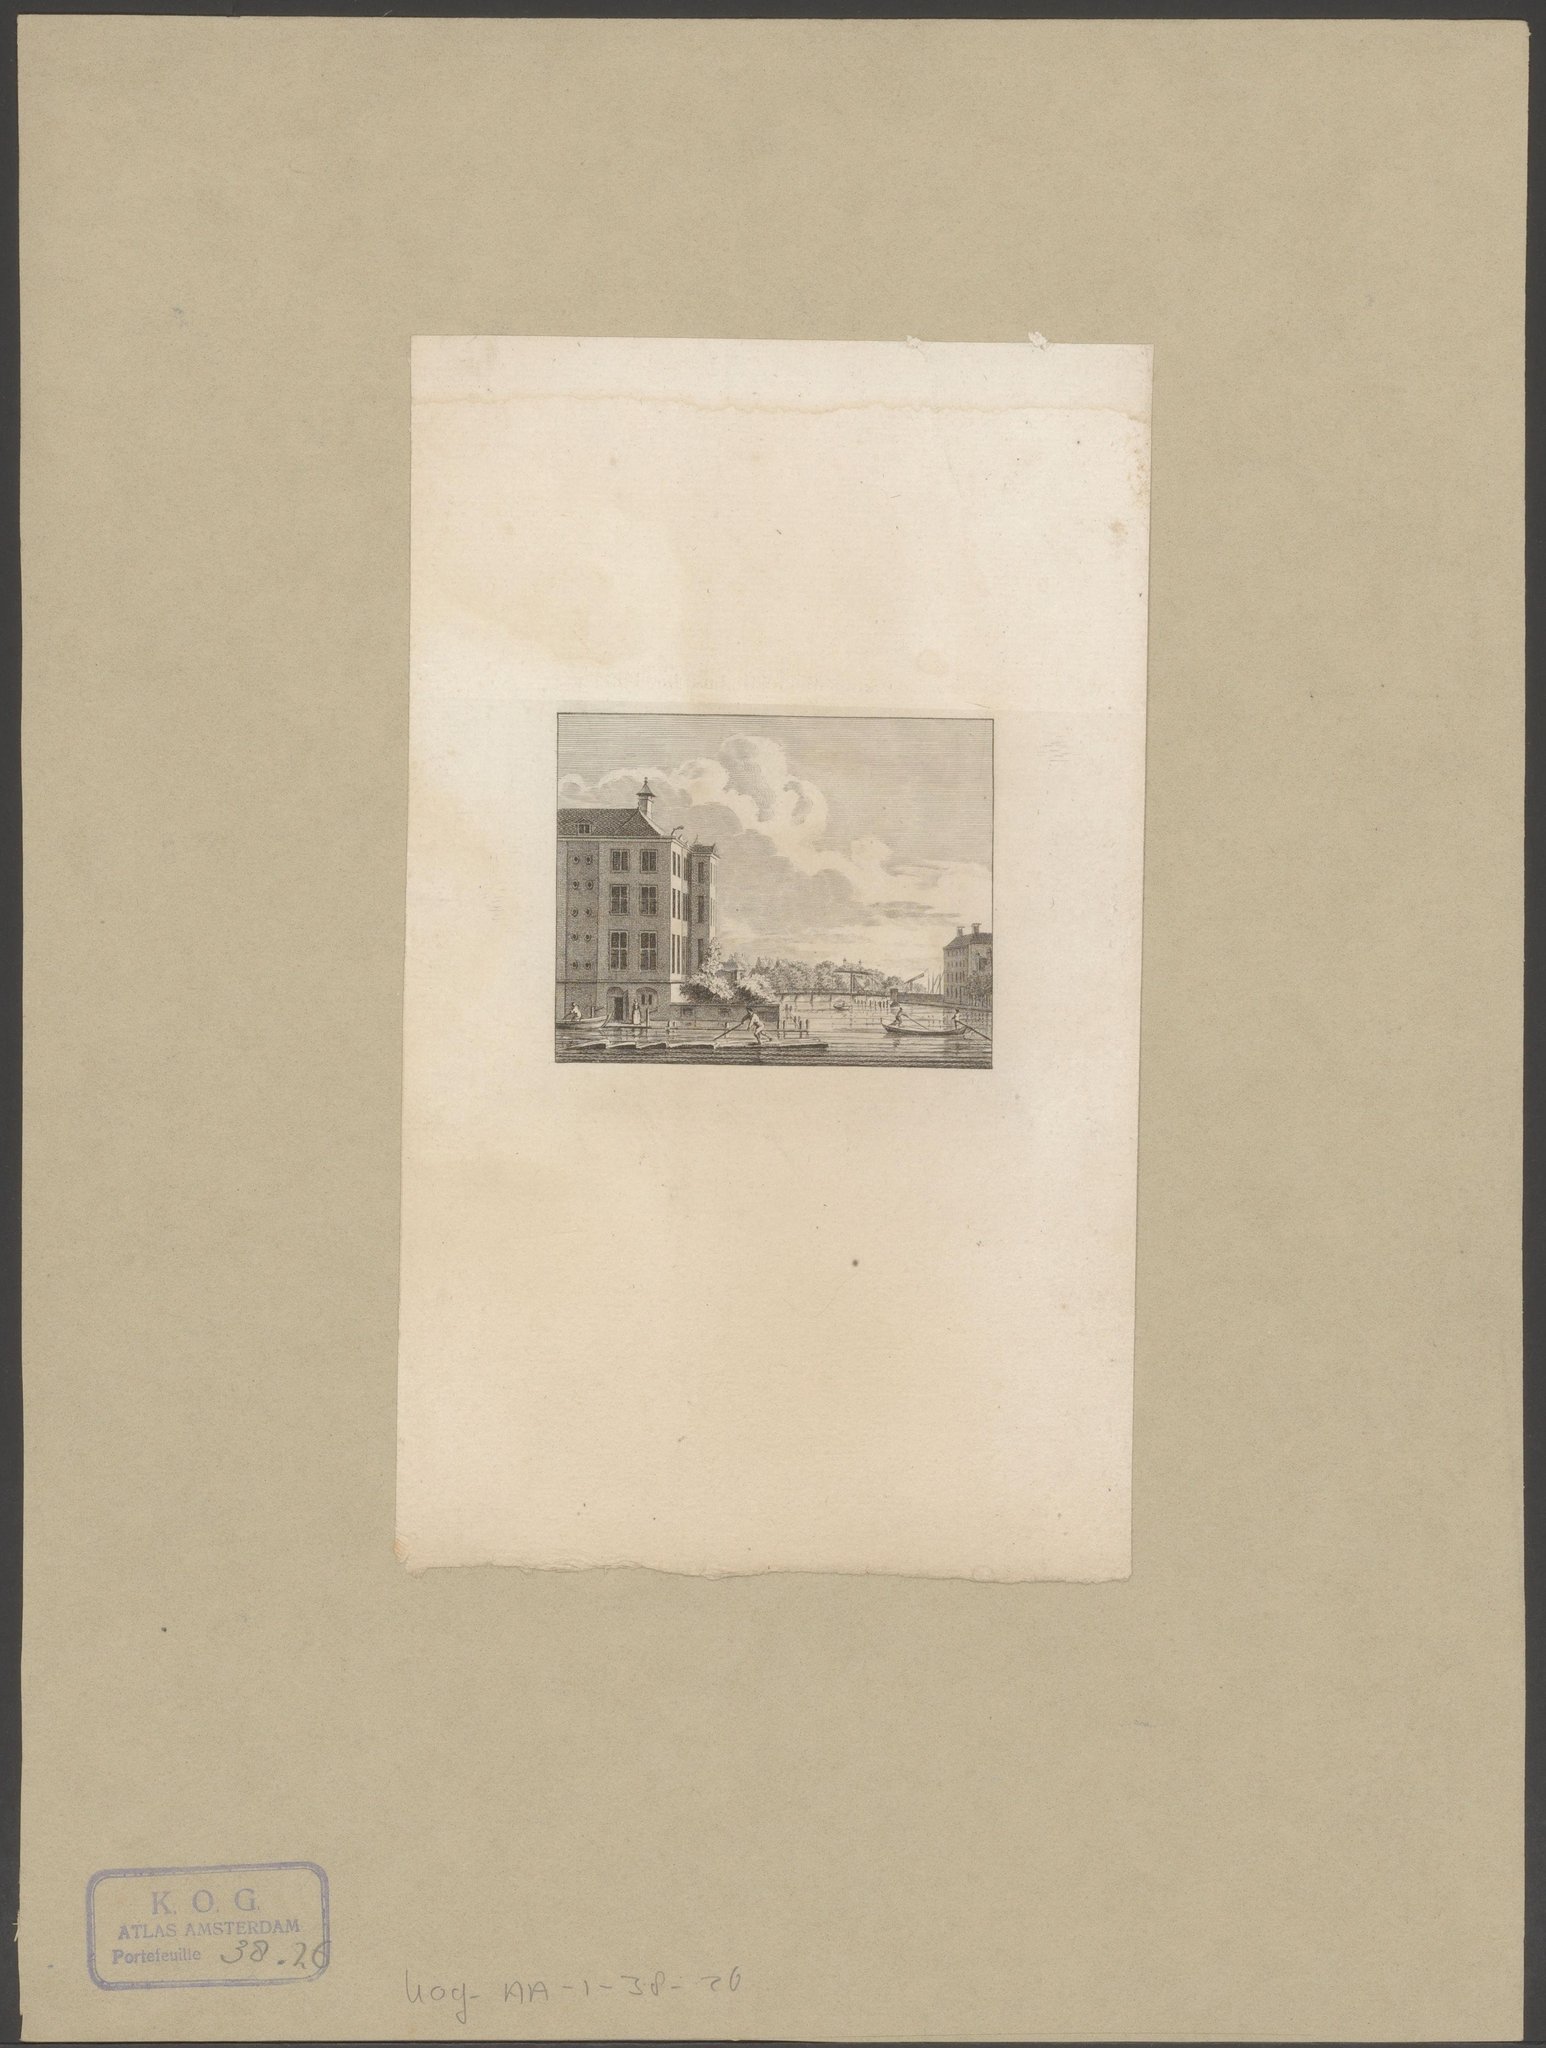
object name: print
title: Gezicht op het Diaconieweeshuis te Amsterdam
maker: cornelis brouwer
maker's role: print maker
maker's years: 1731-1803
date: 1782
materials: paper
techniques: etching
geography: amsterdam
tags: rowing-boat, canoe, etc., orphanage, canals, waters (in city) (+ city(-scape) with figures, staffage)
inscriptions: collector's mark: Lugt 1641b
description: Bovenste helft van plaat, met voorstelling van de Nieuwe en Grote Synagoge te Amsterdam, niet gedrukt. Onderwerpsrubriek binnen de Atlas Amsterdam: Armwezen en liefdadige instellingen: II. Kerkelijke inrichtingen: Diaconie Weeshuis der Ned. Herv. Gem. Zwanenburgerstraat.